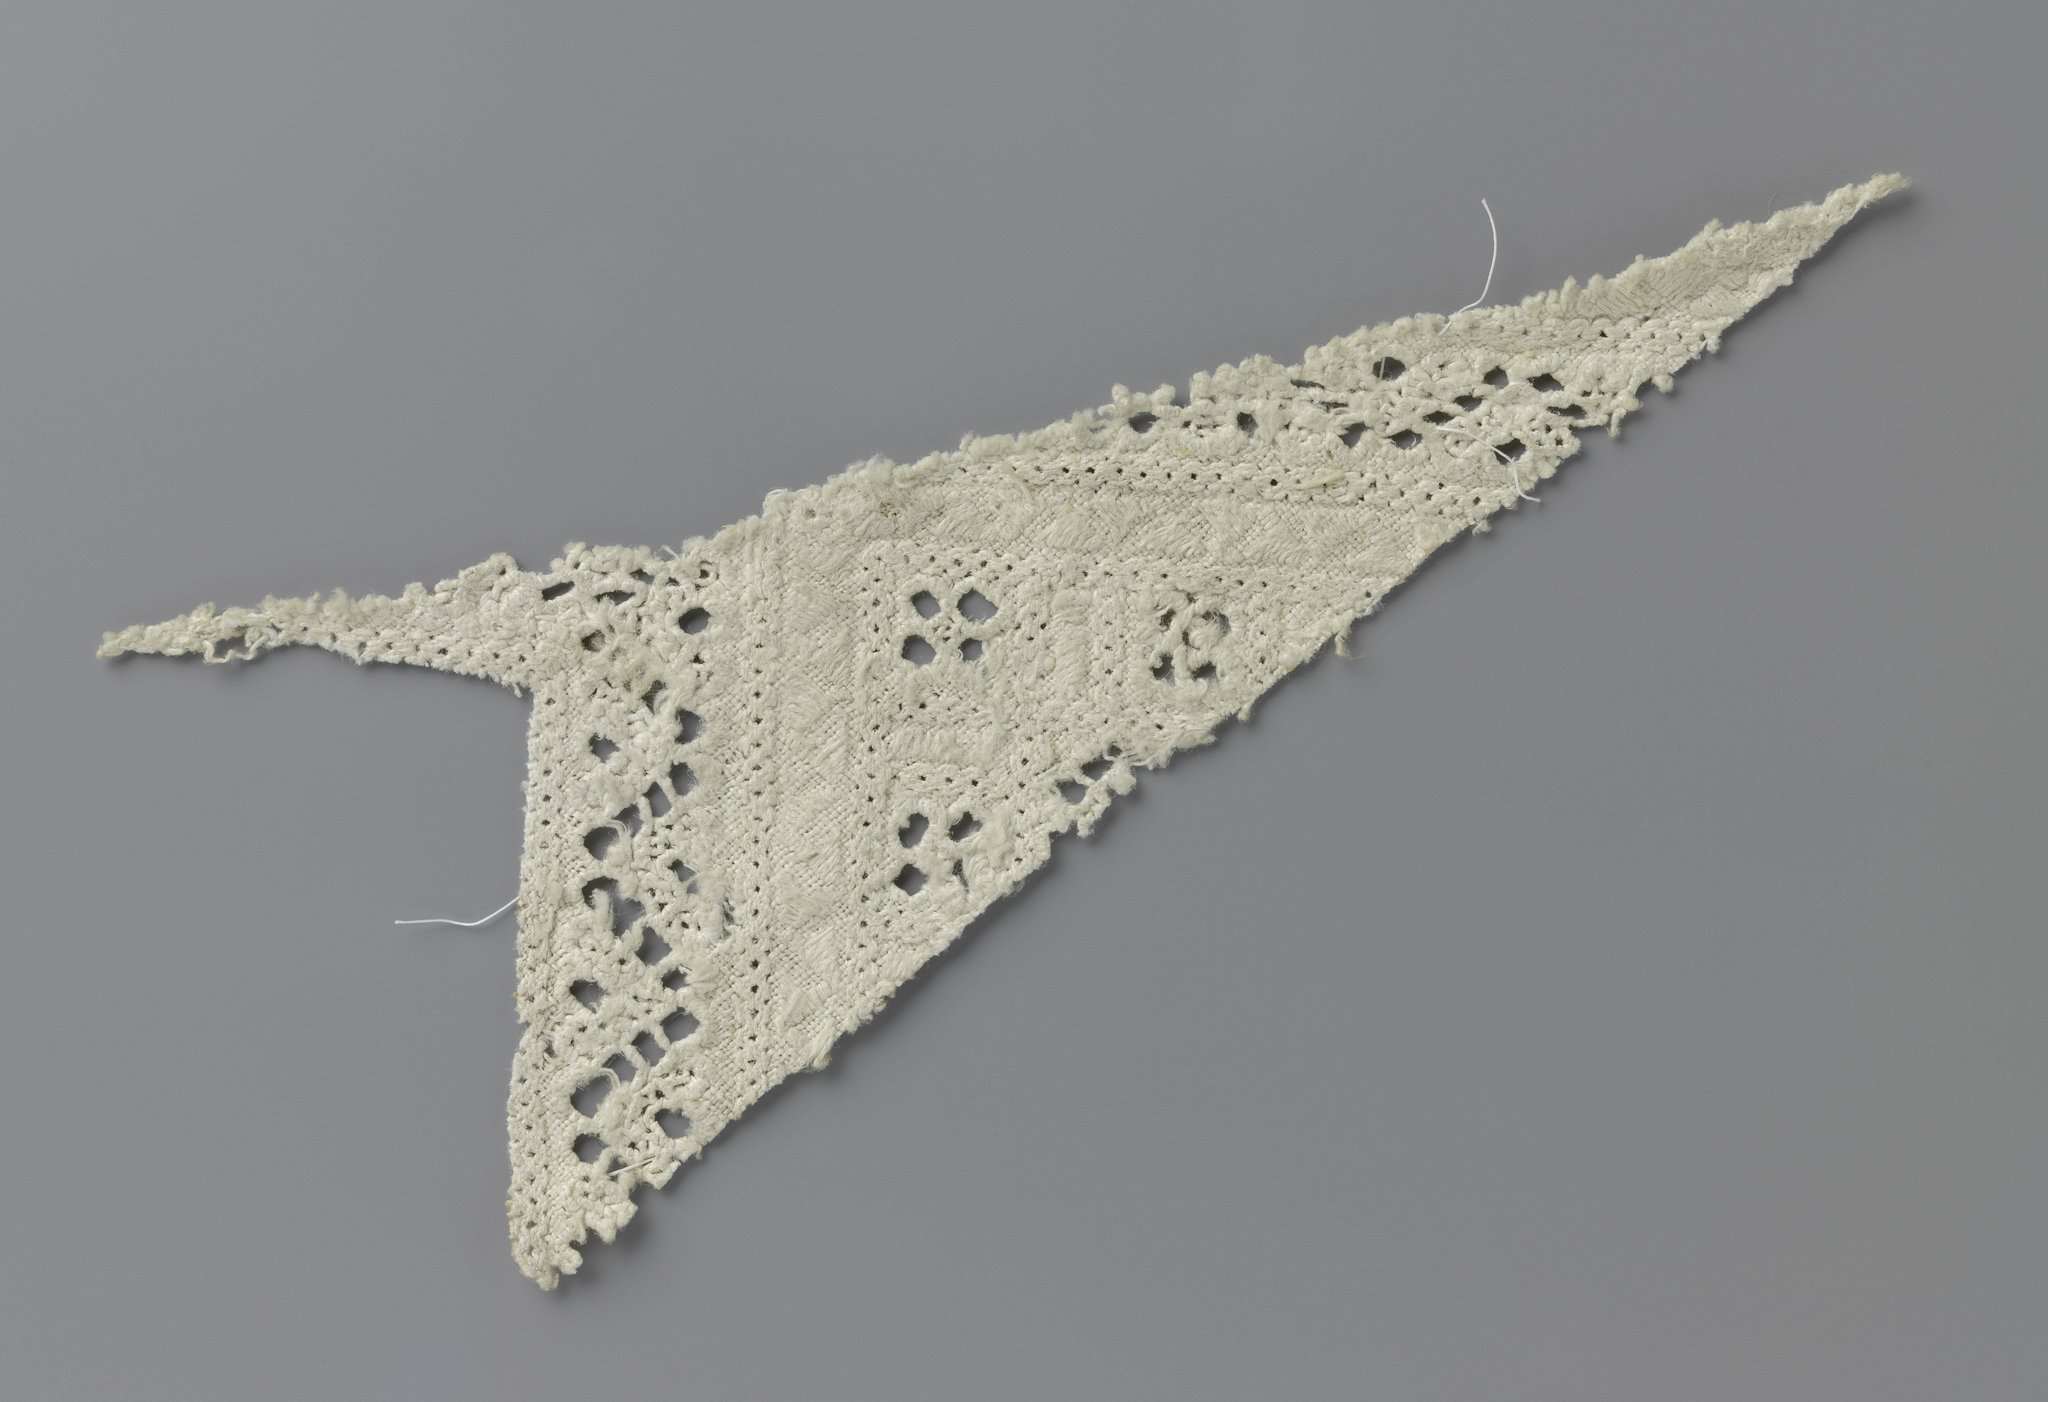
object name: fragment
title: Fragment naaldkant met gekantelde vierkantjes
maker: Anonymous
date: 1500-1599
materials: linen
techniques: needle lace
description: Fragment naturelkleurig naaldkant, gesneden werk. Patroon met uitgesneden, gekantelde vierkantjes.